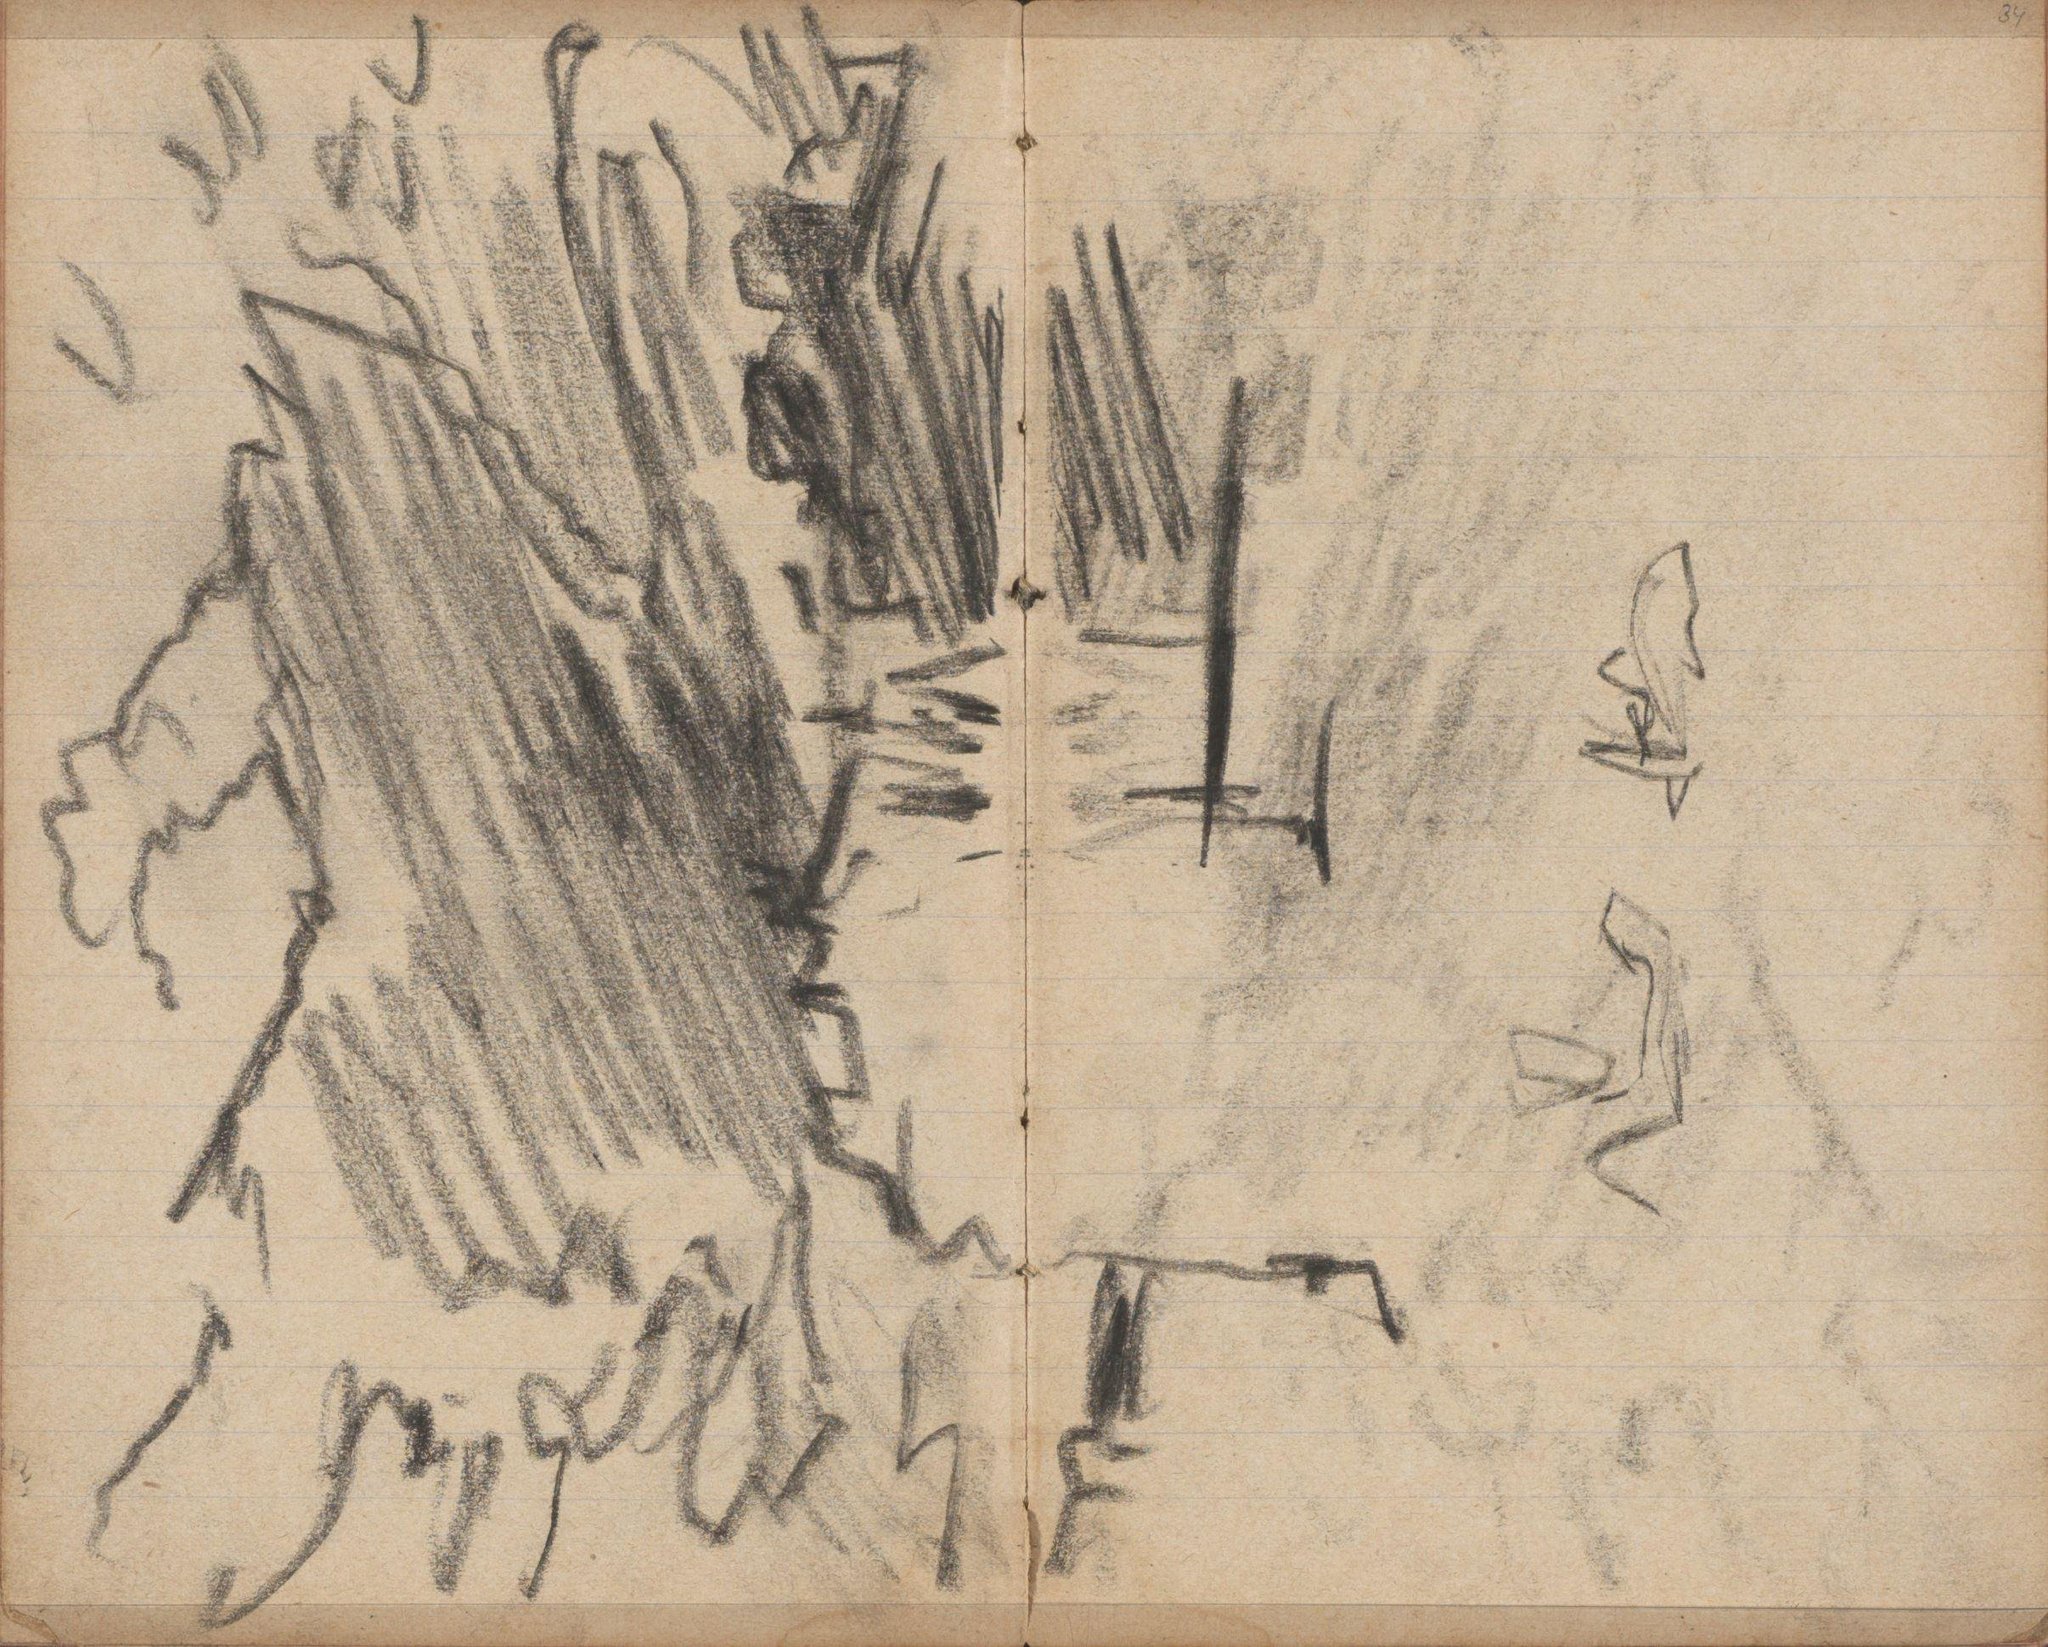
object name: sketchbook leaf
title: Gezicht in Amsterdam met wolkenlucht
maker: george hendrik breitner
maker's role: draughtsman, painter, print maker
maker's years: 1857-1923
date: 1886-1903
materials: chalk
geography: amsterdam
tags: city-view, and landscape with man-made constructions, clouds, amsterdam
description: Pagina 33 en pagina 34 uit een schetsboek met 41 bladen.